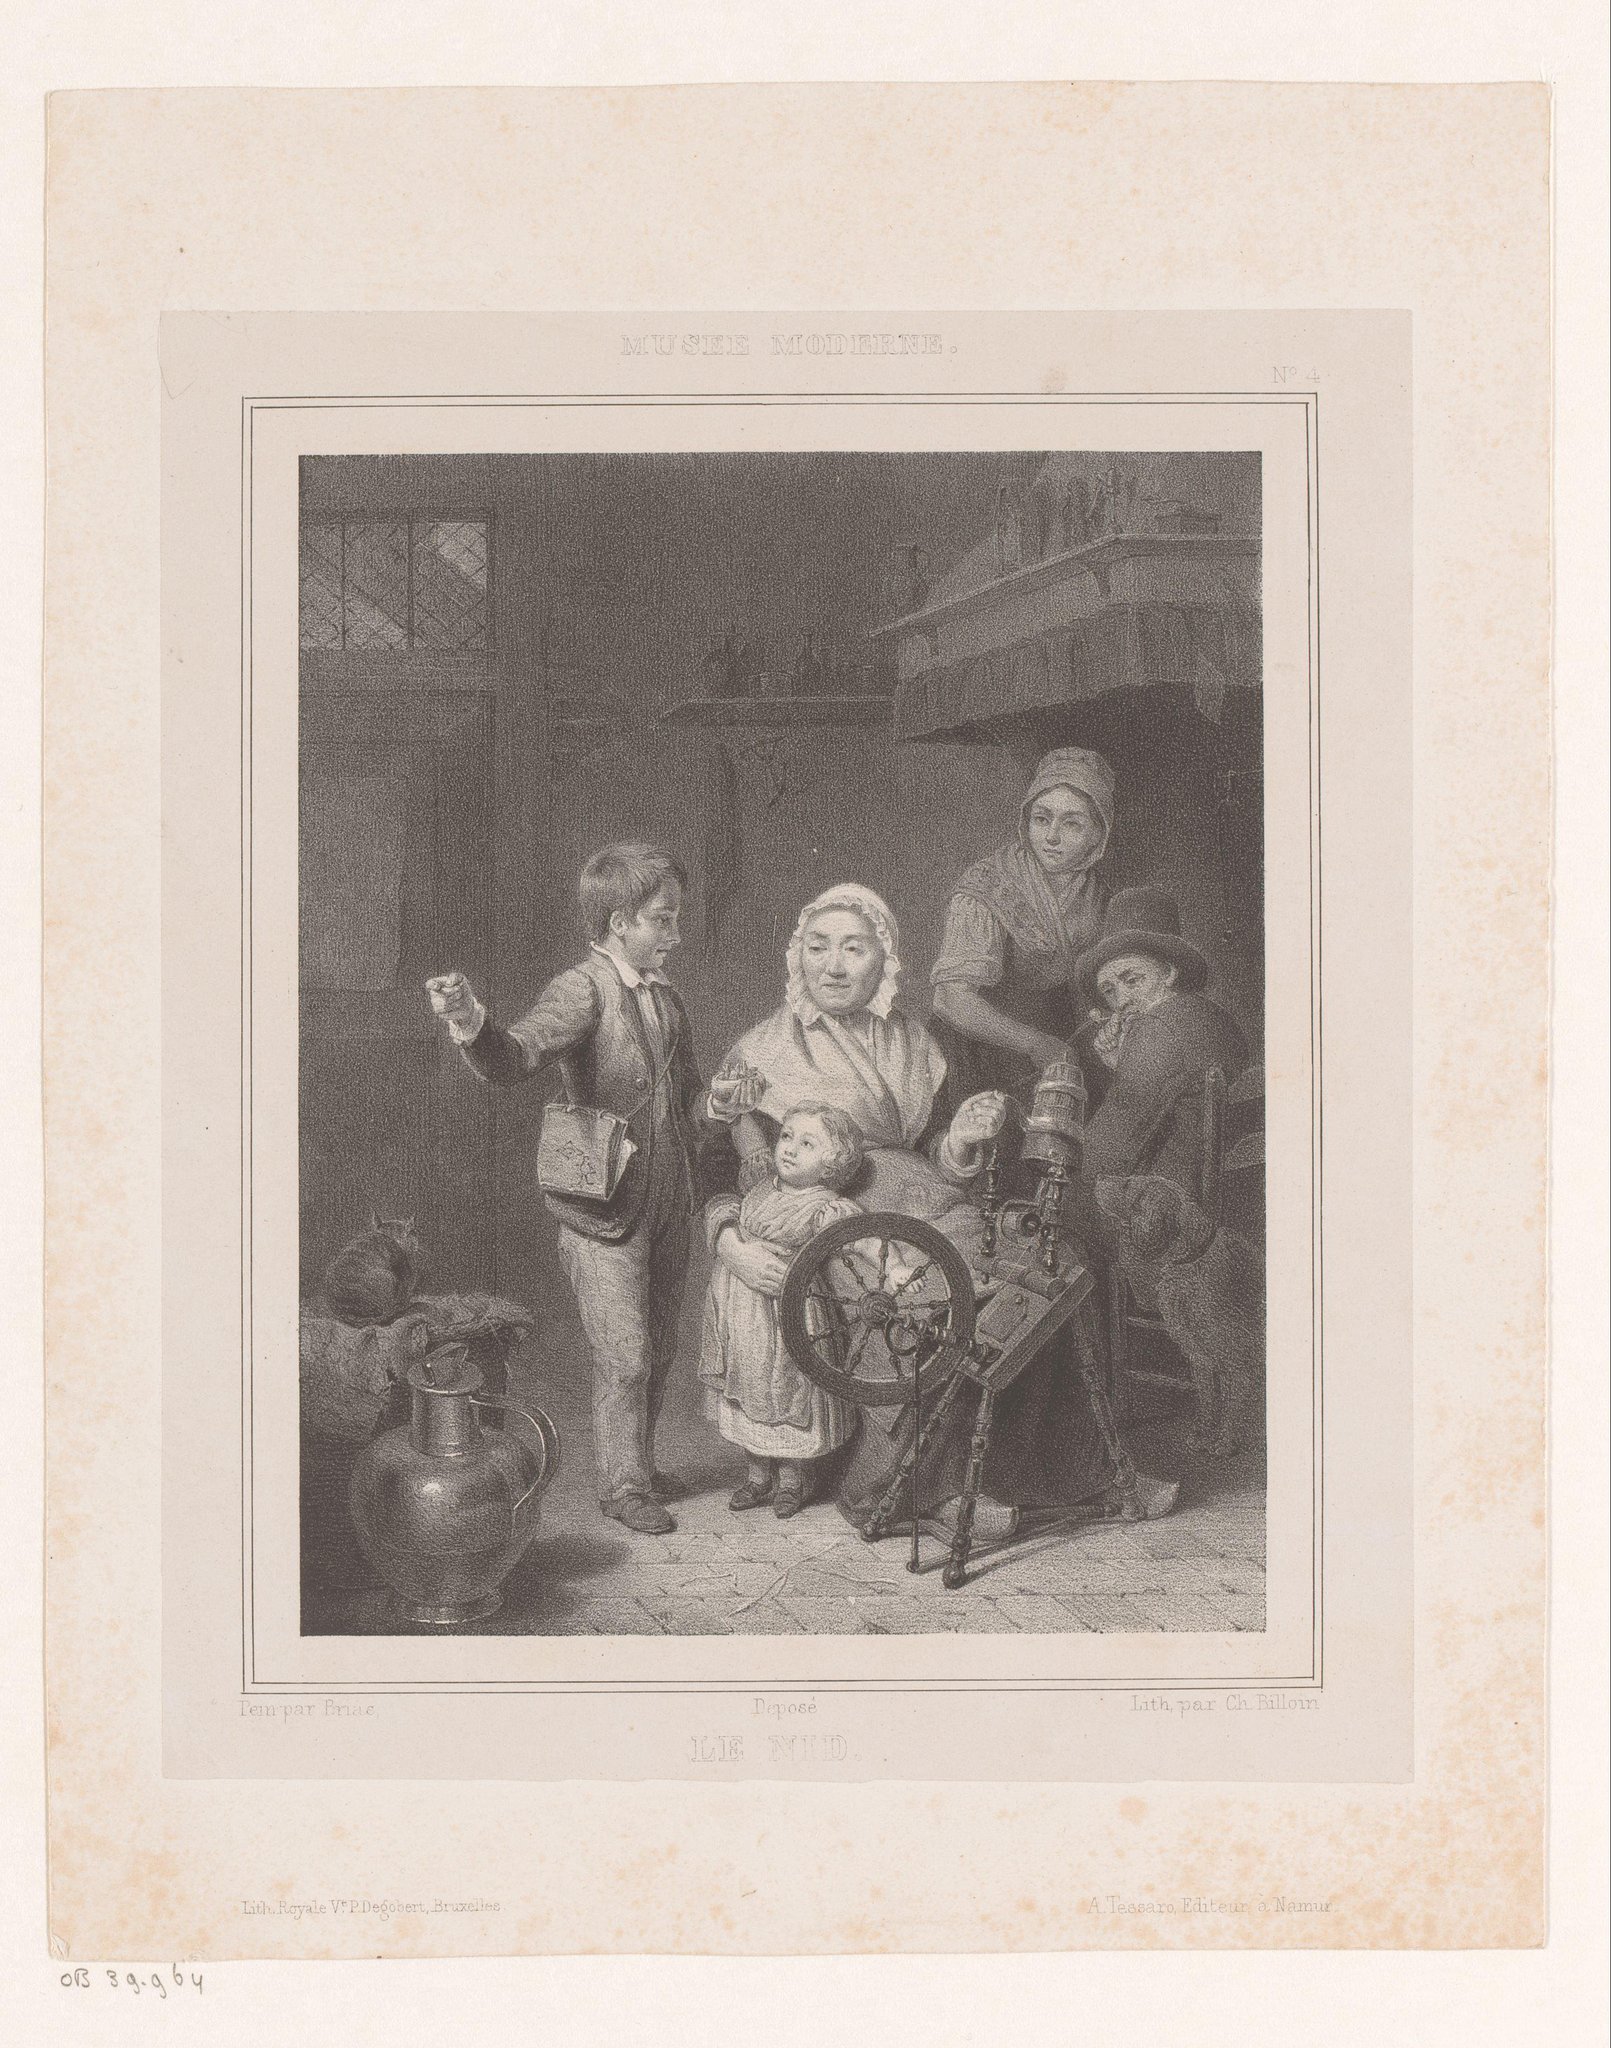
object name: print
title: Kunstwerken van eigentijdse Belgische kunstenaars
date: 1836-1840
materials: paper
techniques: lithograph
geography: brussels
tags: nesting-box, child, spinning-wheel, family life at home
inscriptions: collector's mark: Lugt 2228, : ‘Déposé’